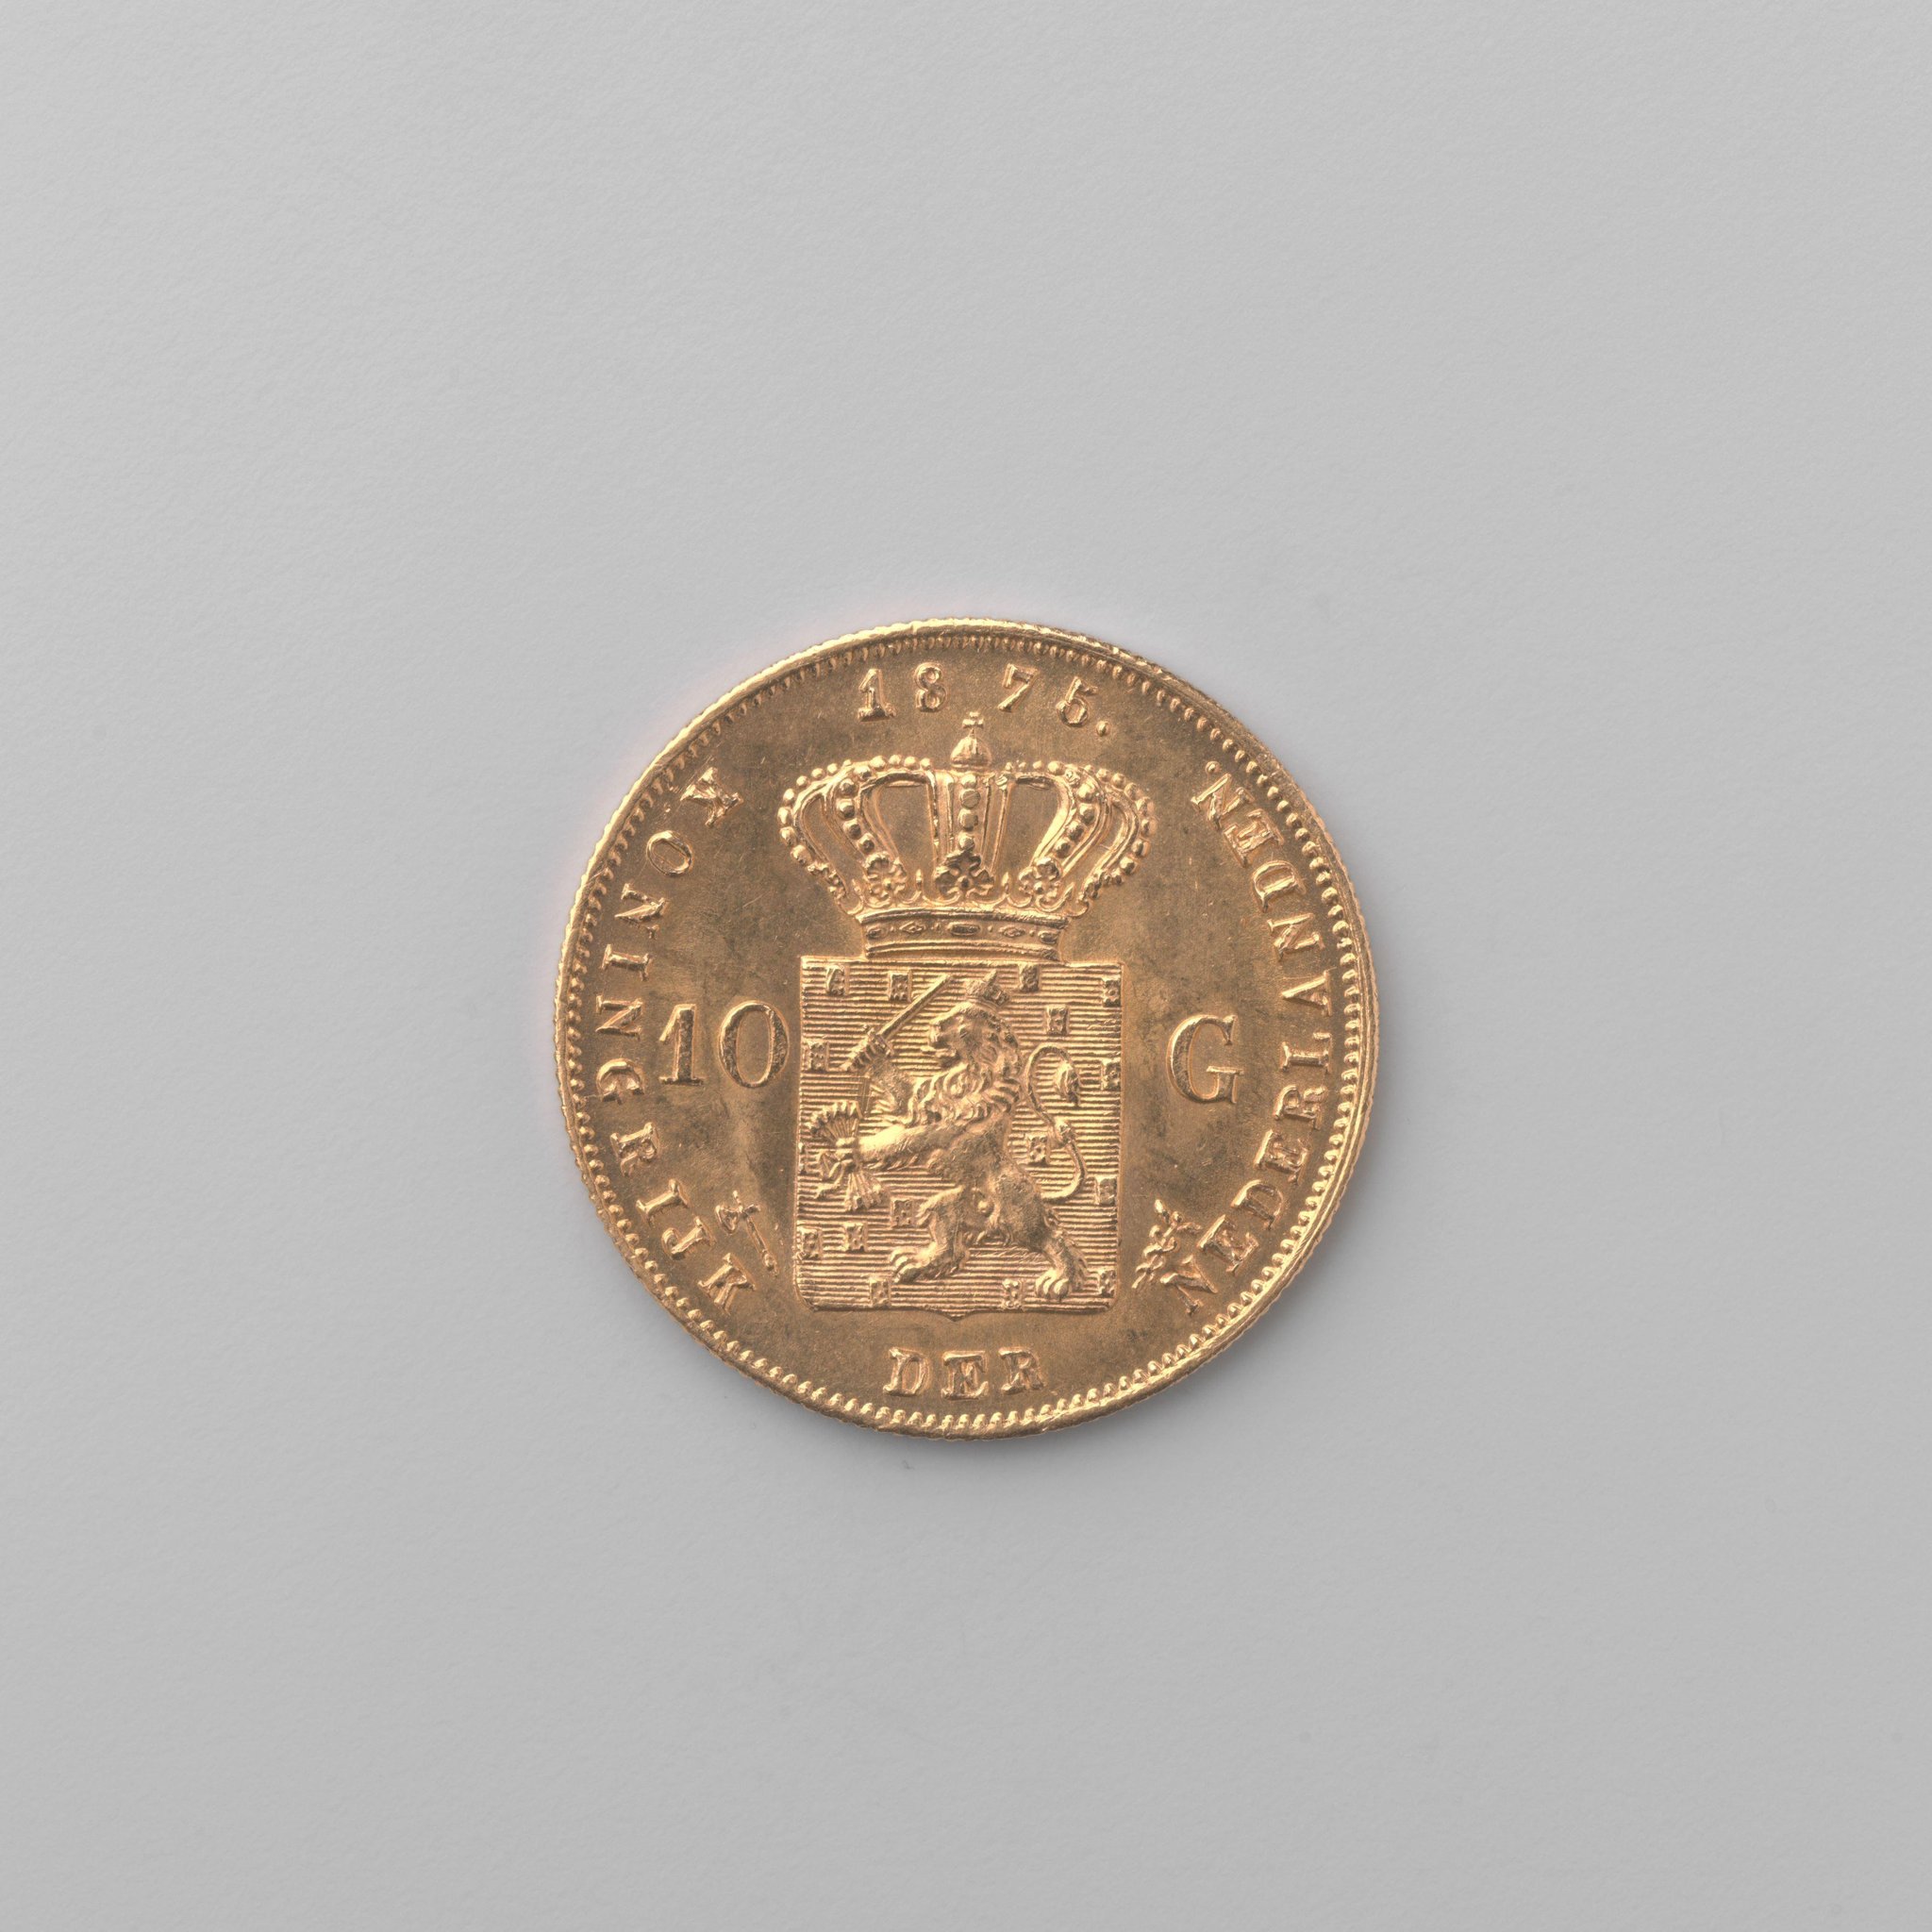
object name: tien gulden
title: Nederland, 10 gulden, 1875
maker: willem iii (koning der nederlanden)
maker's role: koning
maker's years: 1817-1890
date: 1875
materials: gold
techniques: striking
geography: utrecht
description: Gouden munt. Voorzijde:hoofd naar rechts.Keerzijde: tussen waarde-aanduiding 10 G gekroond rijkswapenschild. Jaartal bovenaan in omschrift. Kartelrand.